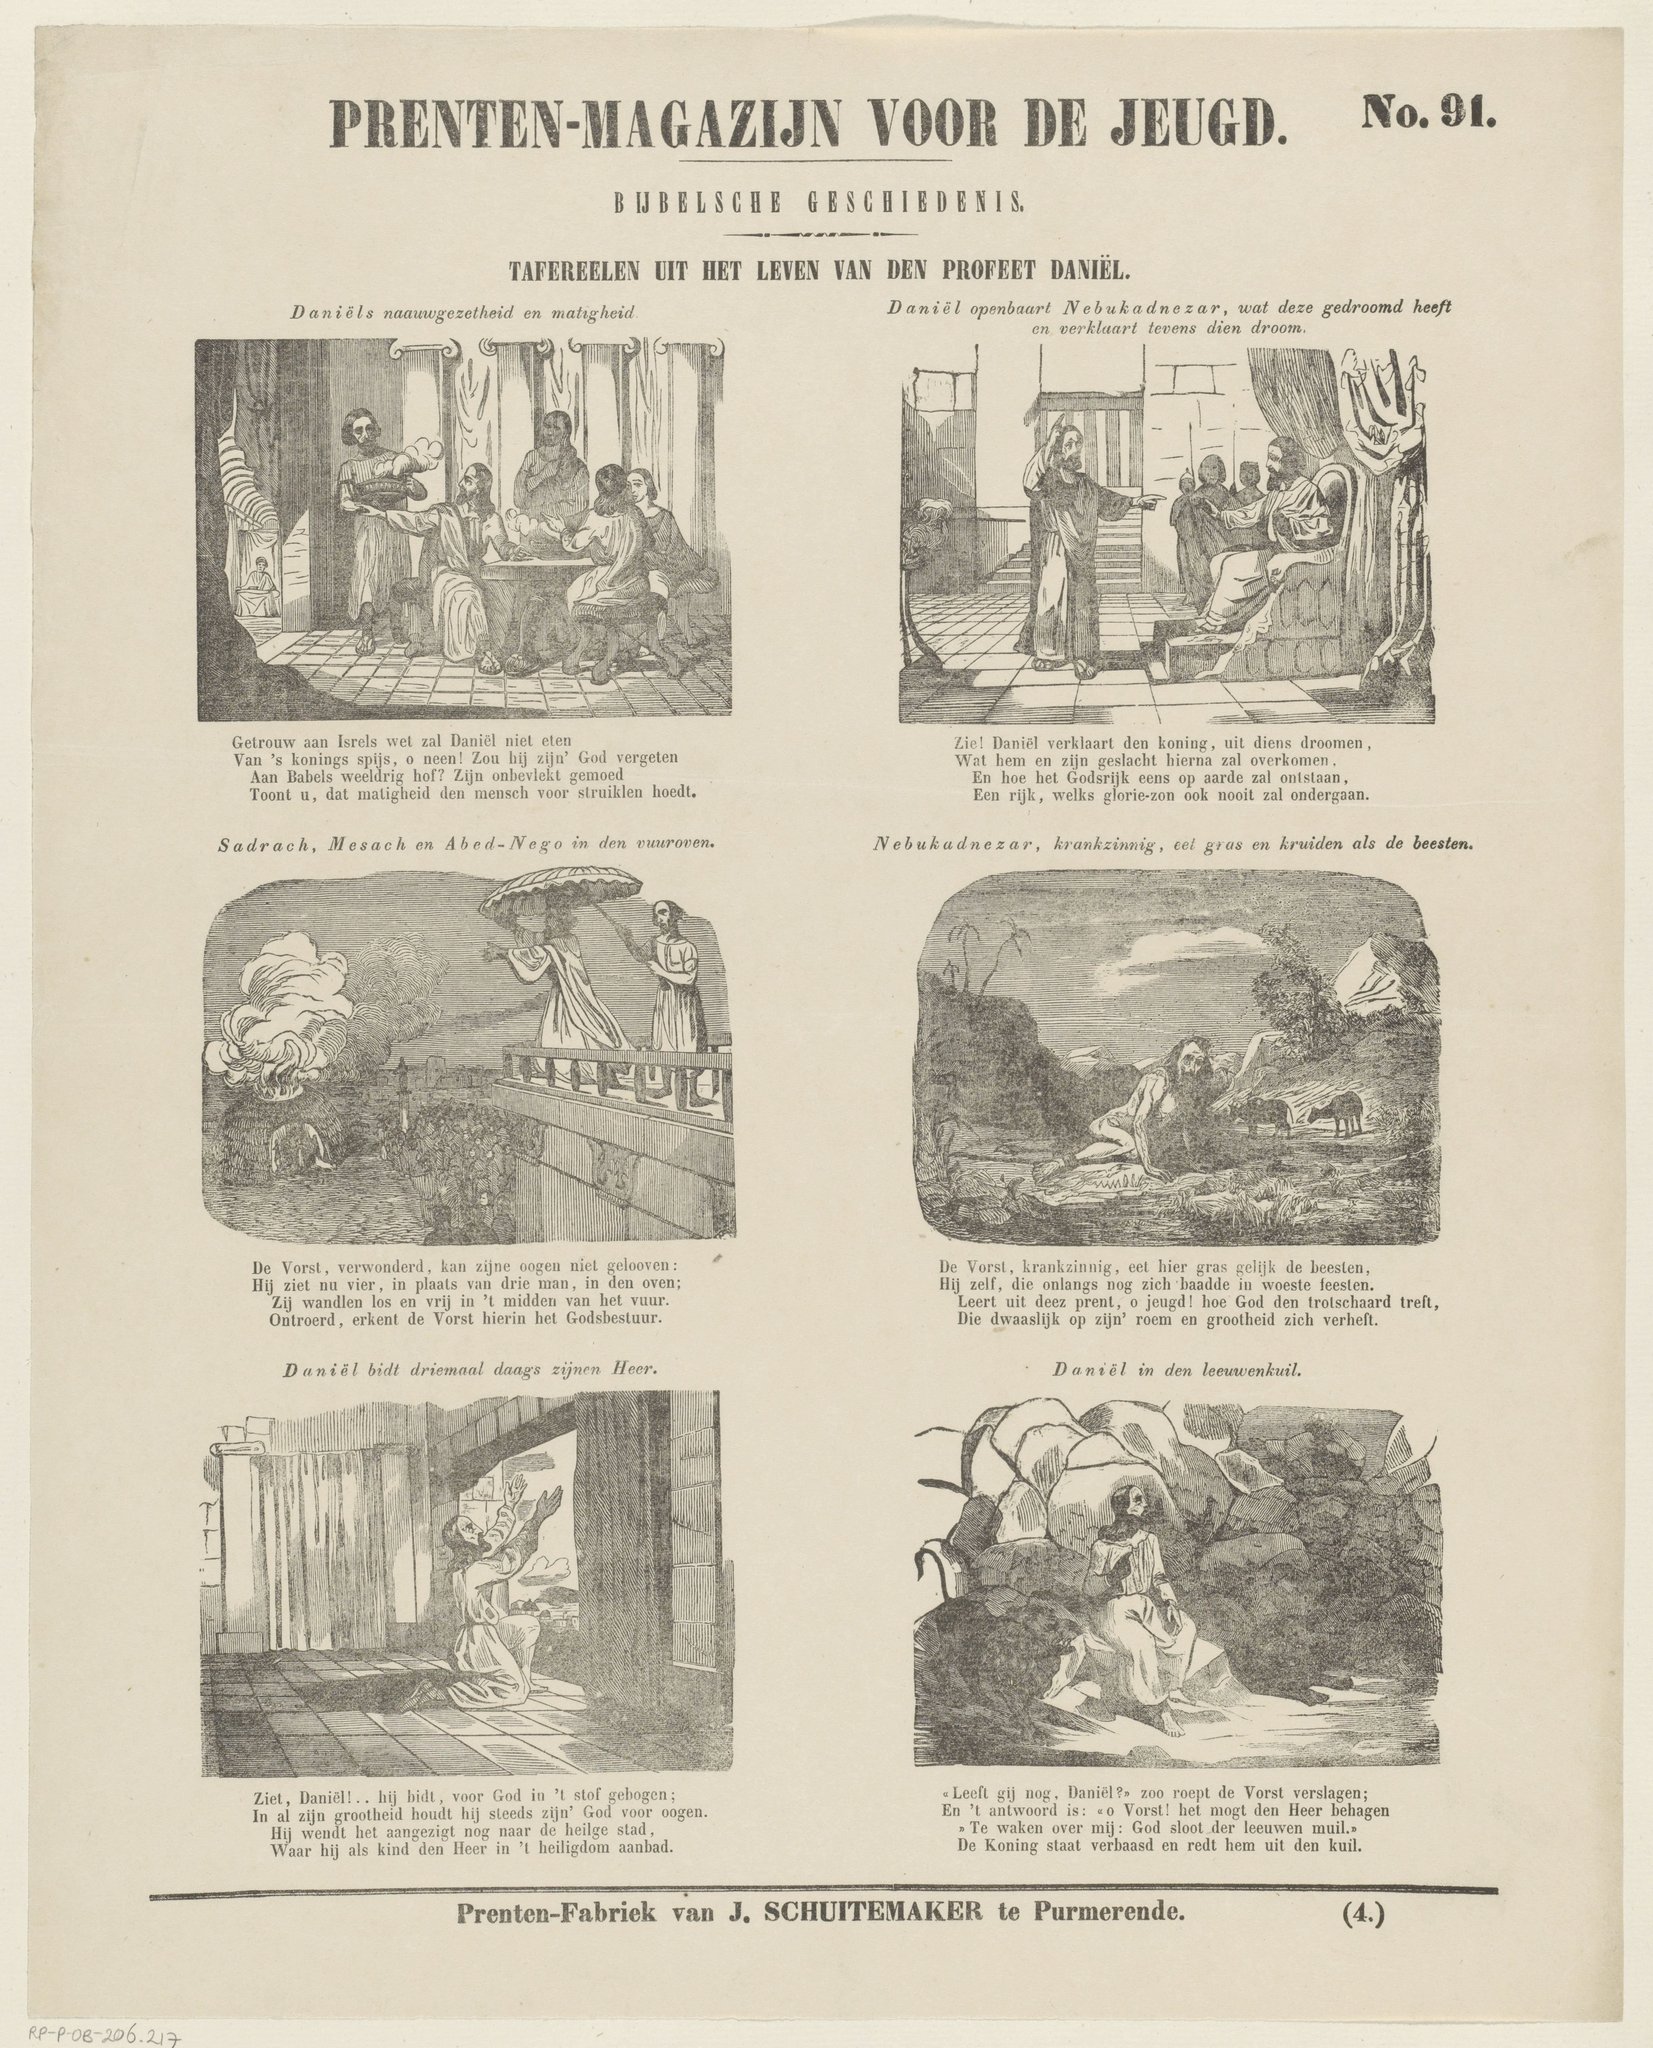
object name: popular print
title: Bijbelsche geschiedenis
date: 1850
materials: paper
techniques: letterpress printing, engraving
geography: purmerend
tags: the story of the prophet daniel; his visions and prophecies, old testament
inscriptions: collector's mark: Lugt 2760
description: Na voltooiing van de acht jaargangen van de reeks 'Prenten-magazijn voor de jeugd' in 1850 heeft Jan Schuitemaker al deze prenten heruitgegeven en omgenummerd als nr. 1 t/m 192. De oorspronkelijke jaargang wordt telkens nog vermeld rechtsonder op de prent. Binnen de jaargangen zijn prenten van hetzelfde thema in clusters van vier achter elkaar gezet.